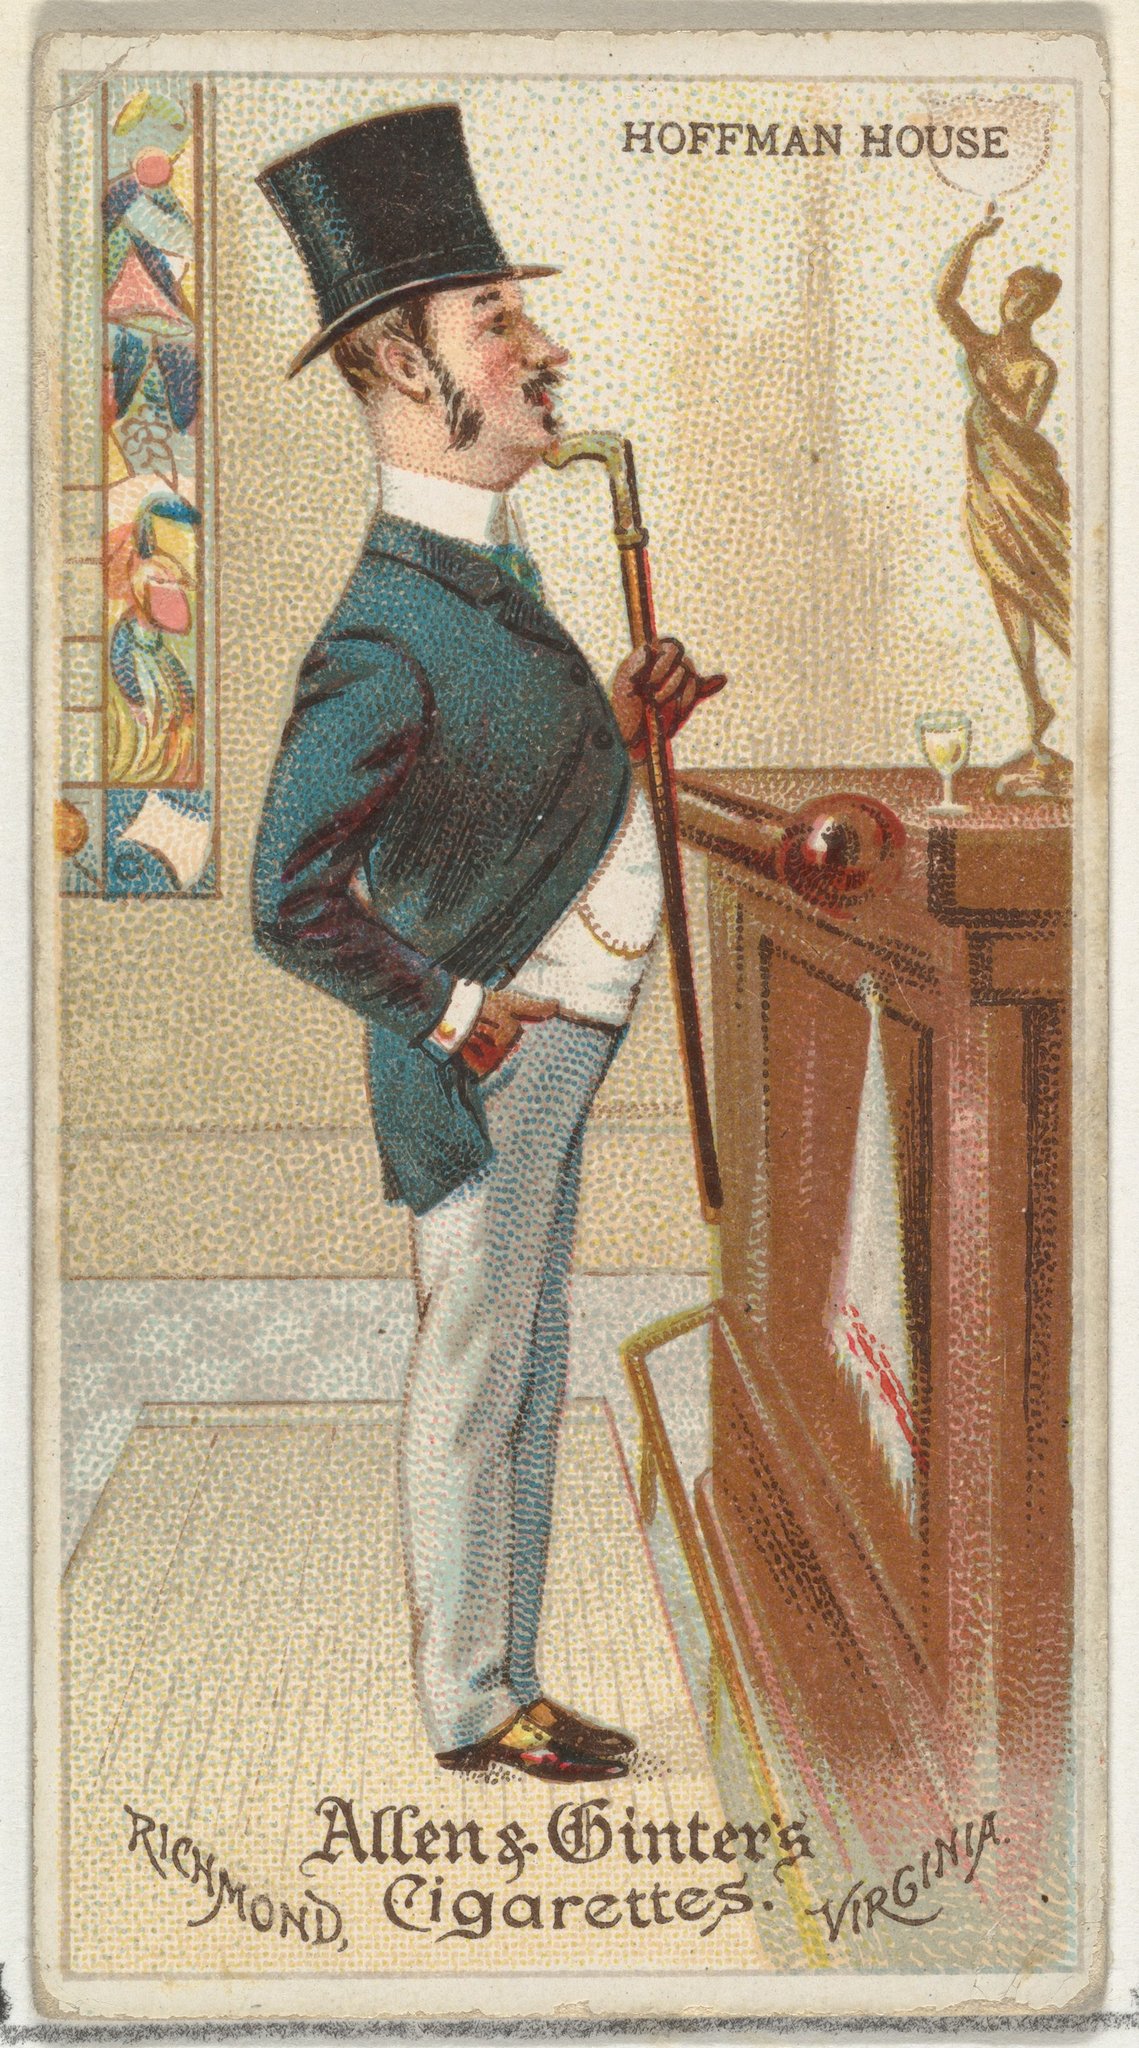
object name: print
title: Hoffman House, from World's Dudes series (N31) for Allen & Ginter Cigarettes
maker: allen & ginter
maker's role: publisher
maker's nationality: american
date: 1888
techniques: color lithograph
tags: men